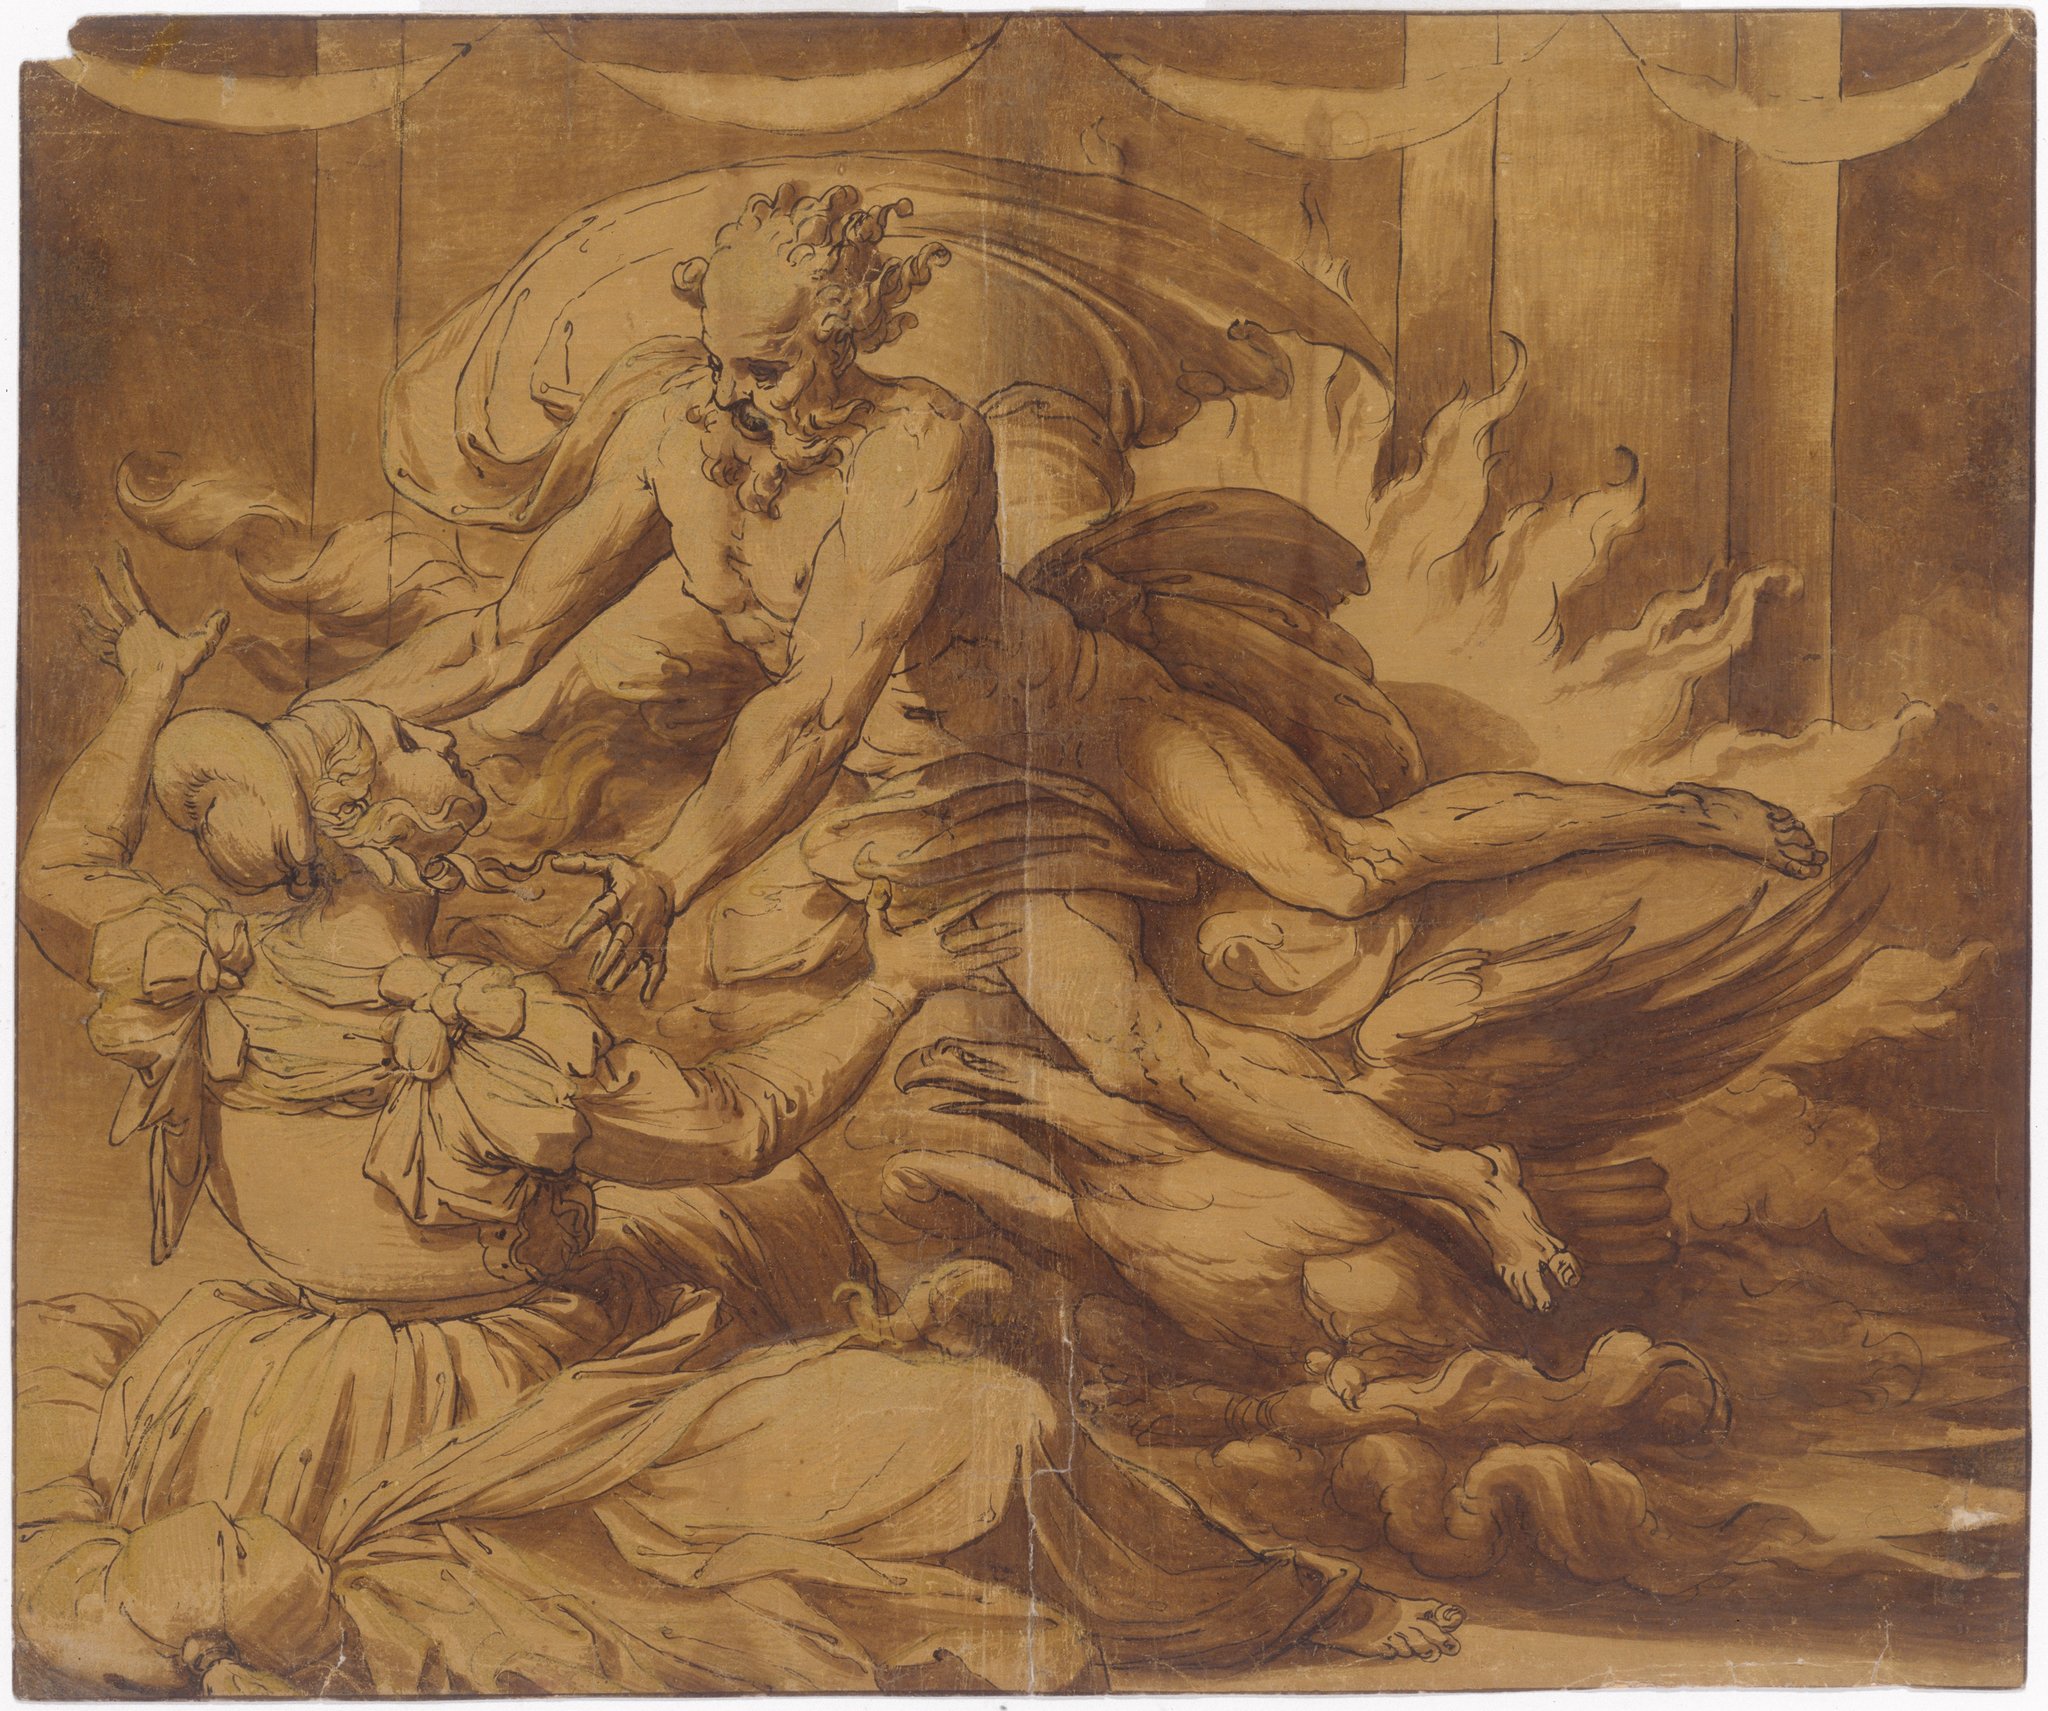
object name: drawing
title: Jupiter Appearing to Semele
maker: perino del vaga (pietro buonaccorsi)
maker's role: artist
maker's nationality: italian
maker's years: 1501-1547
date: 1501-1547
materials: gouache, ink, paper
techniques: brush, highlighting, pen, wash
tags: eagles,women,jupiter